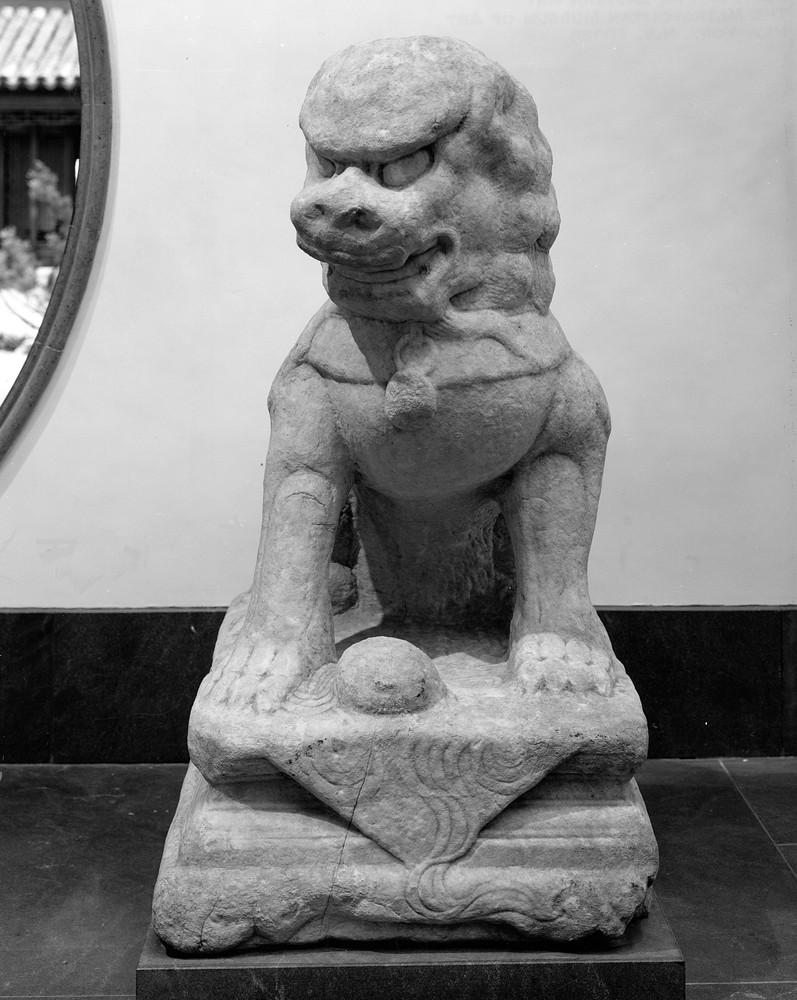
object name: statue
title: Seated Lion (one of a pair)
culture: chinese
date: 1368-1644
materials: marble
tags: lions